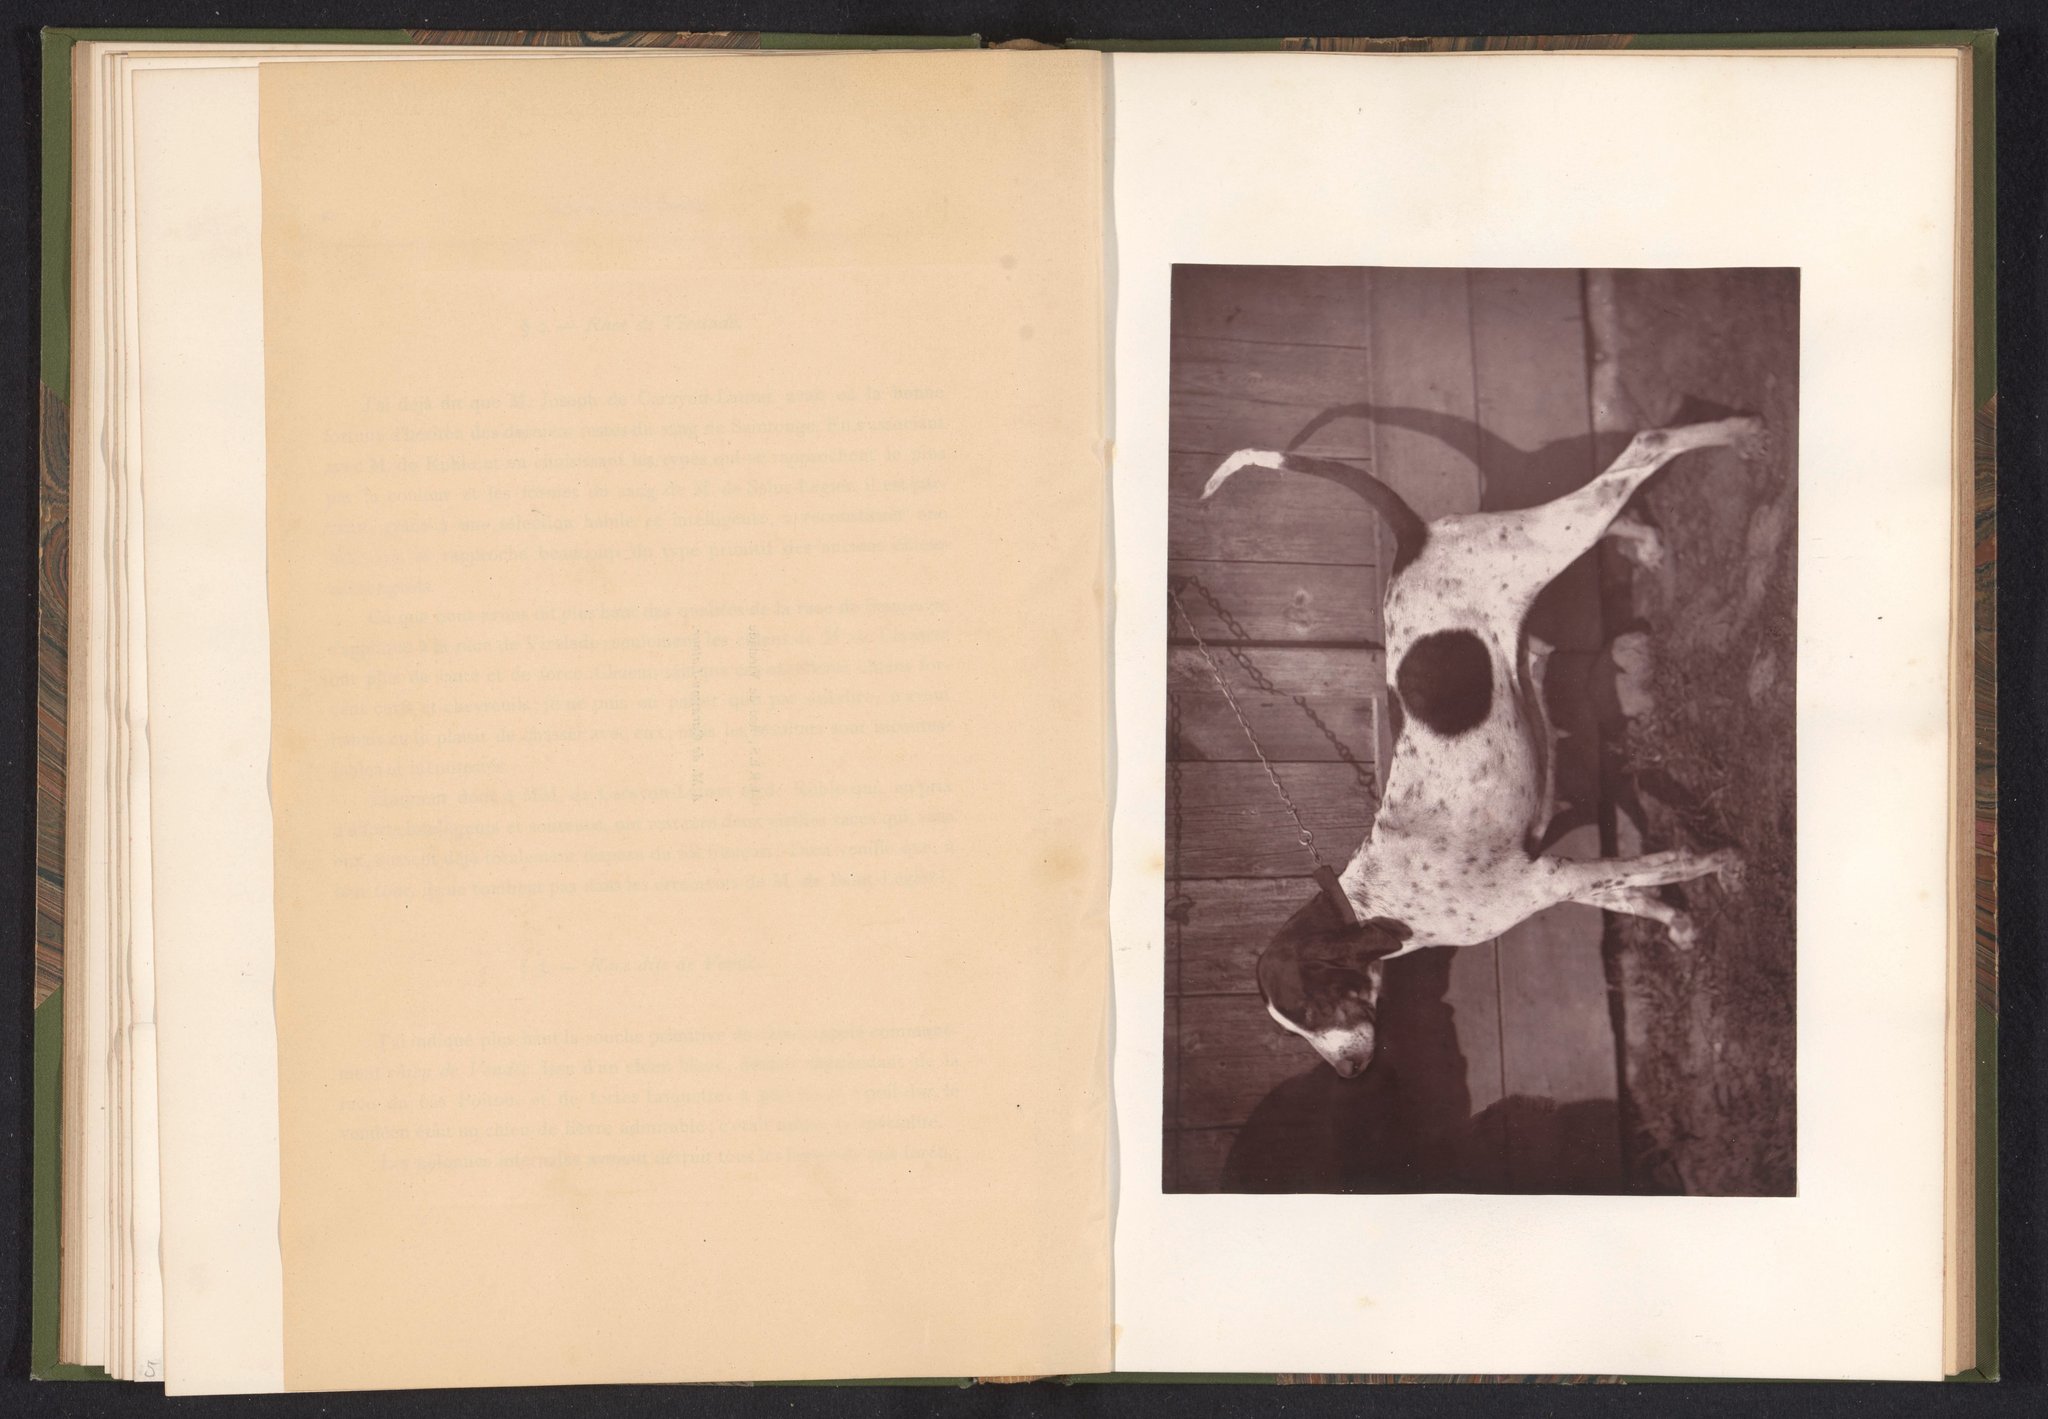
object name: page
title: Jachthond, genaamd Cérès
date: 1869-1879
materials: paper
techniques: woodburytype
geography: france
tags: hunting dogs